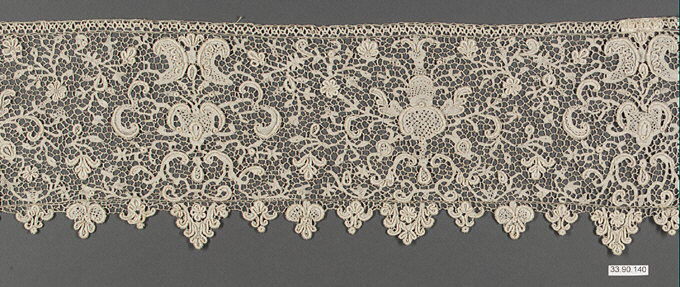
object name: edging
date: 1701-1733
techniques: lace